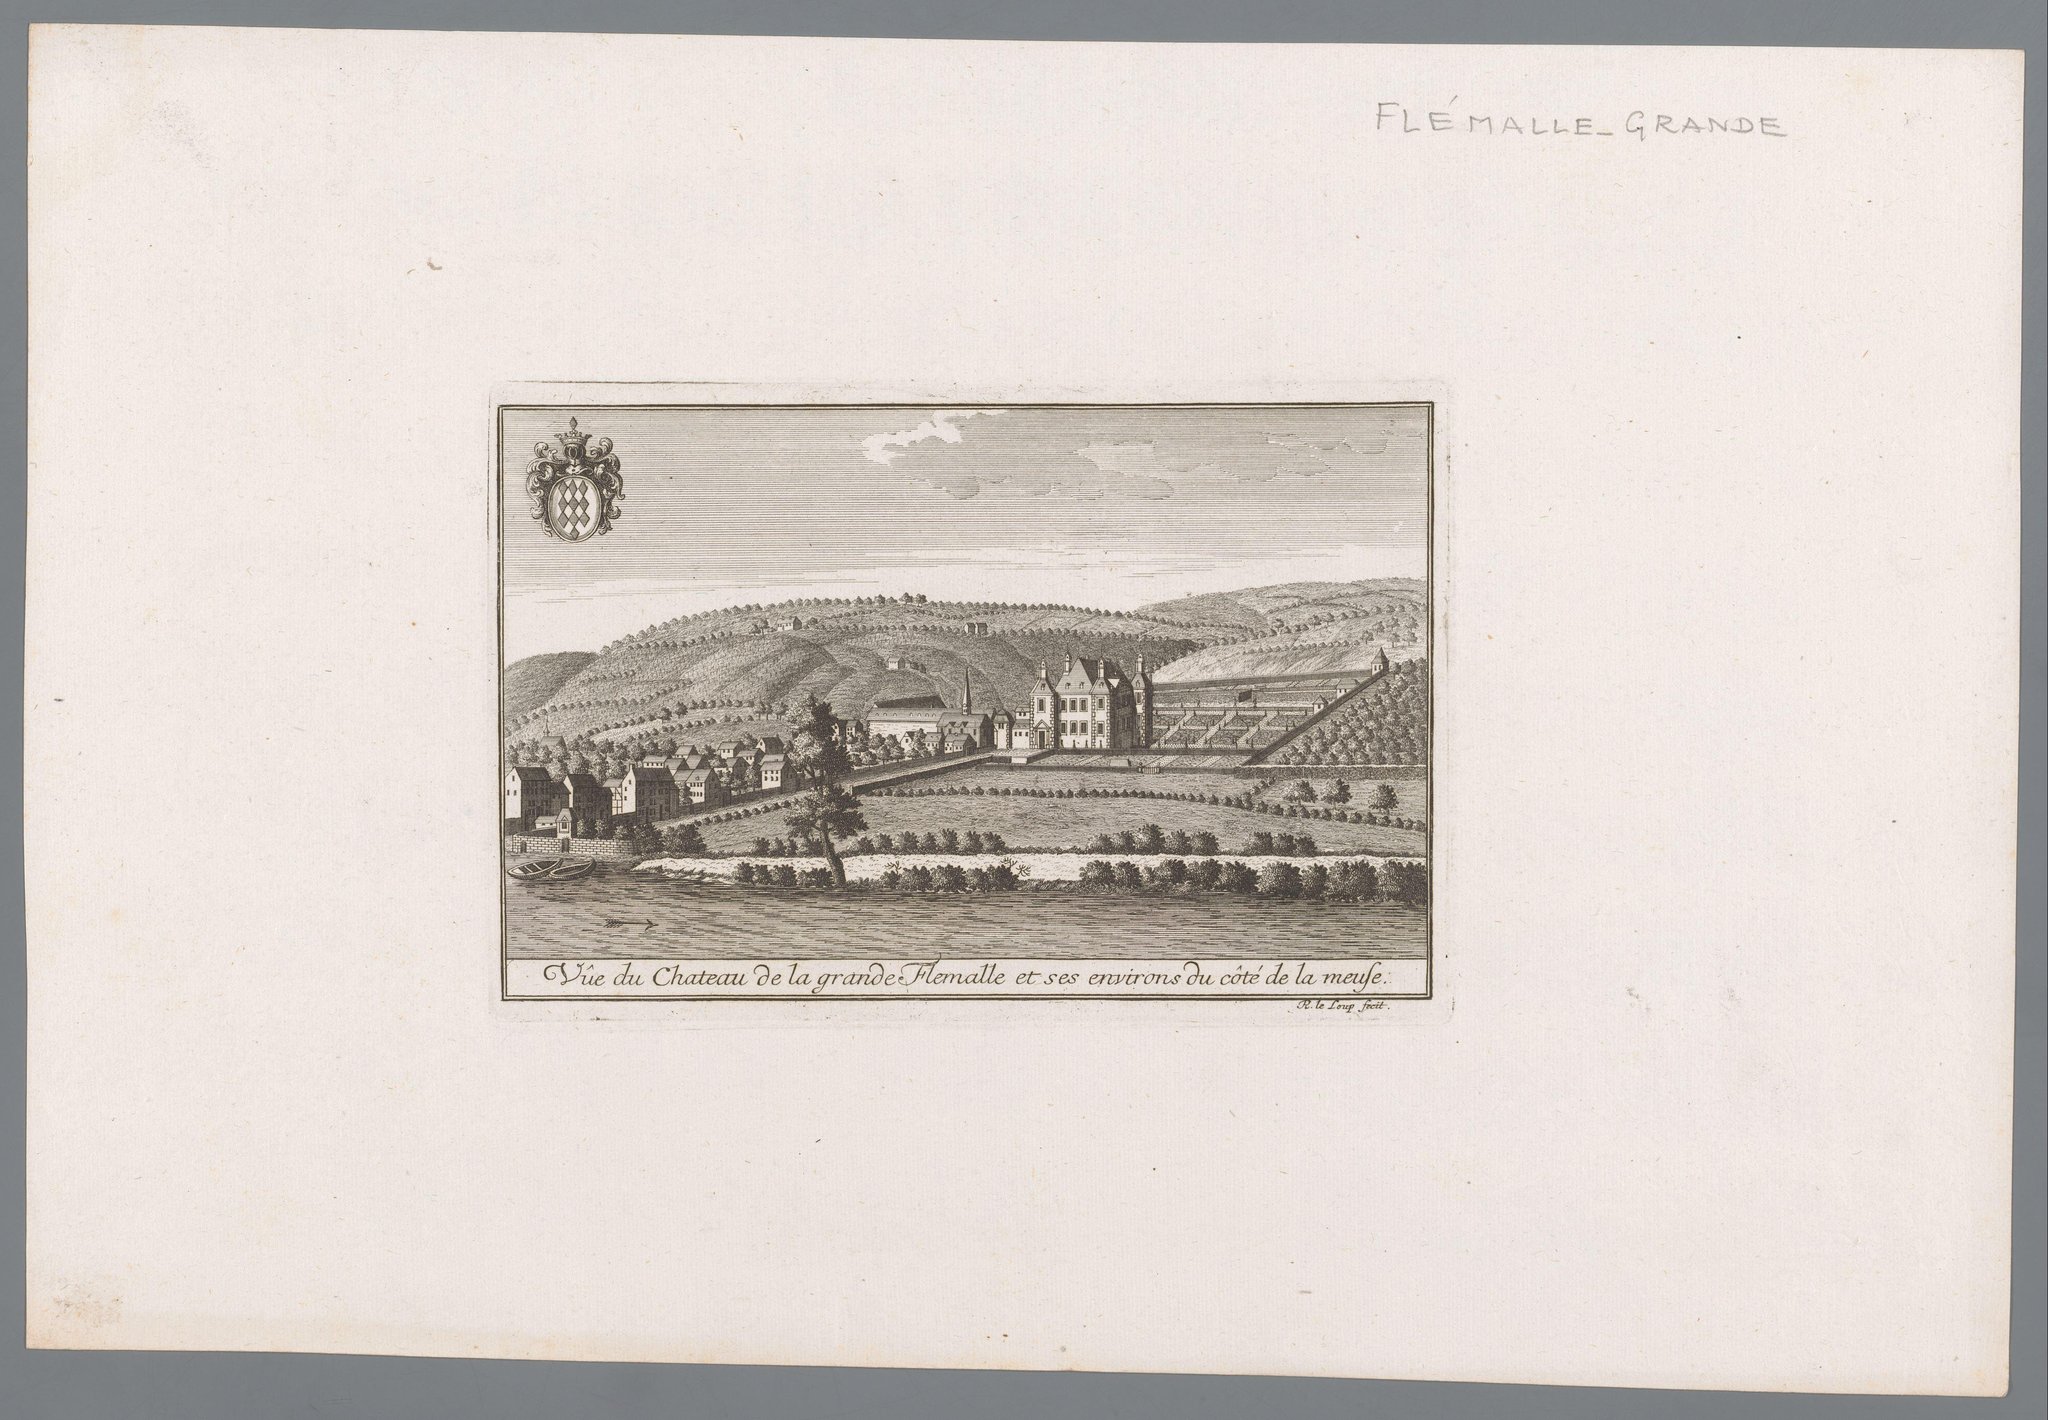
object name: print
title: Gezicht op het kasteel van Flémalle-Grande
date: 1738-1744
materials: paper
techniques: engraving, etching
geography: liège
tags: castle, landscape with tower or castle, liège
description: Prent uit: Johanne de Saumery, Alexandre de et al. Les délices du païs de Liège, ou description géographique, topographique et chorographique des monumes sacrés et profanes (...). 5 dln. Luik: Everard Kints, 1738-1744, dl. 1, voor p. 341.